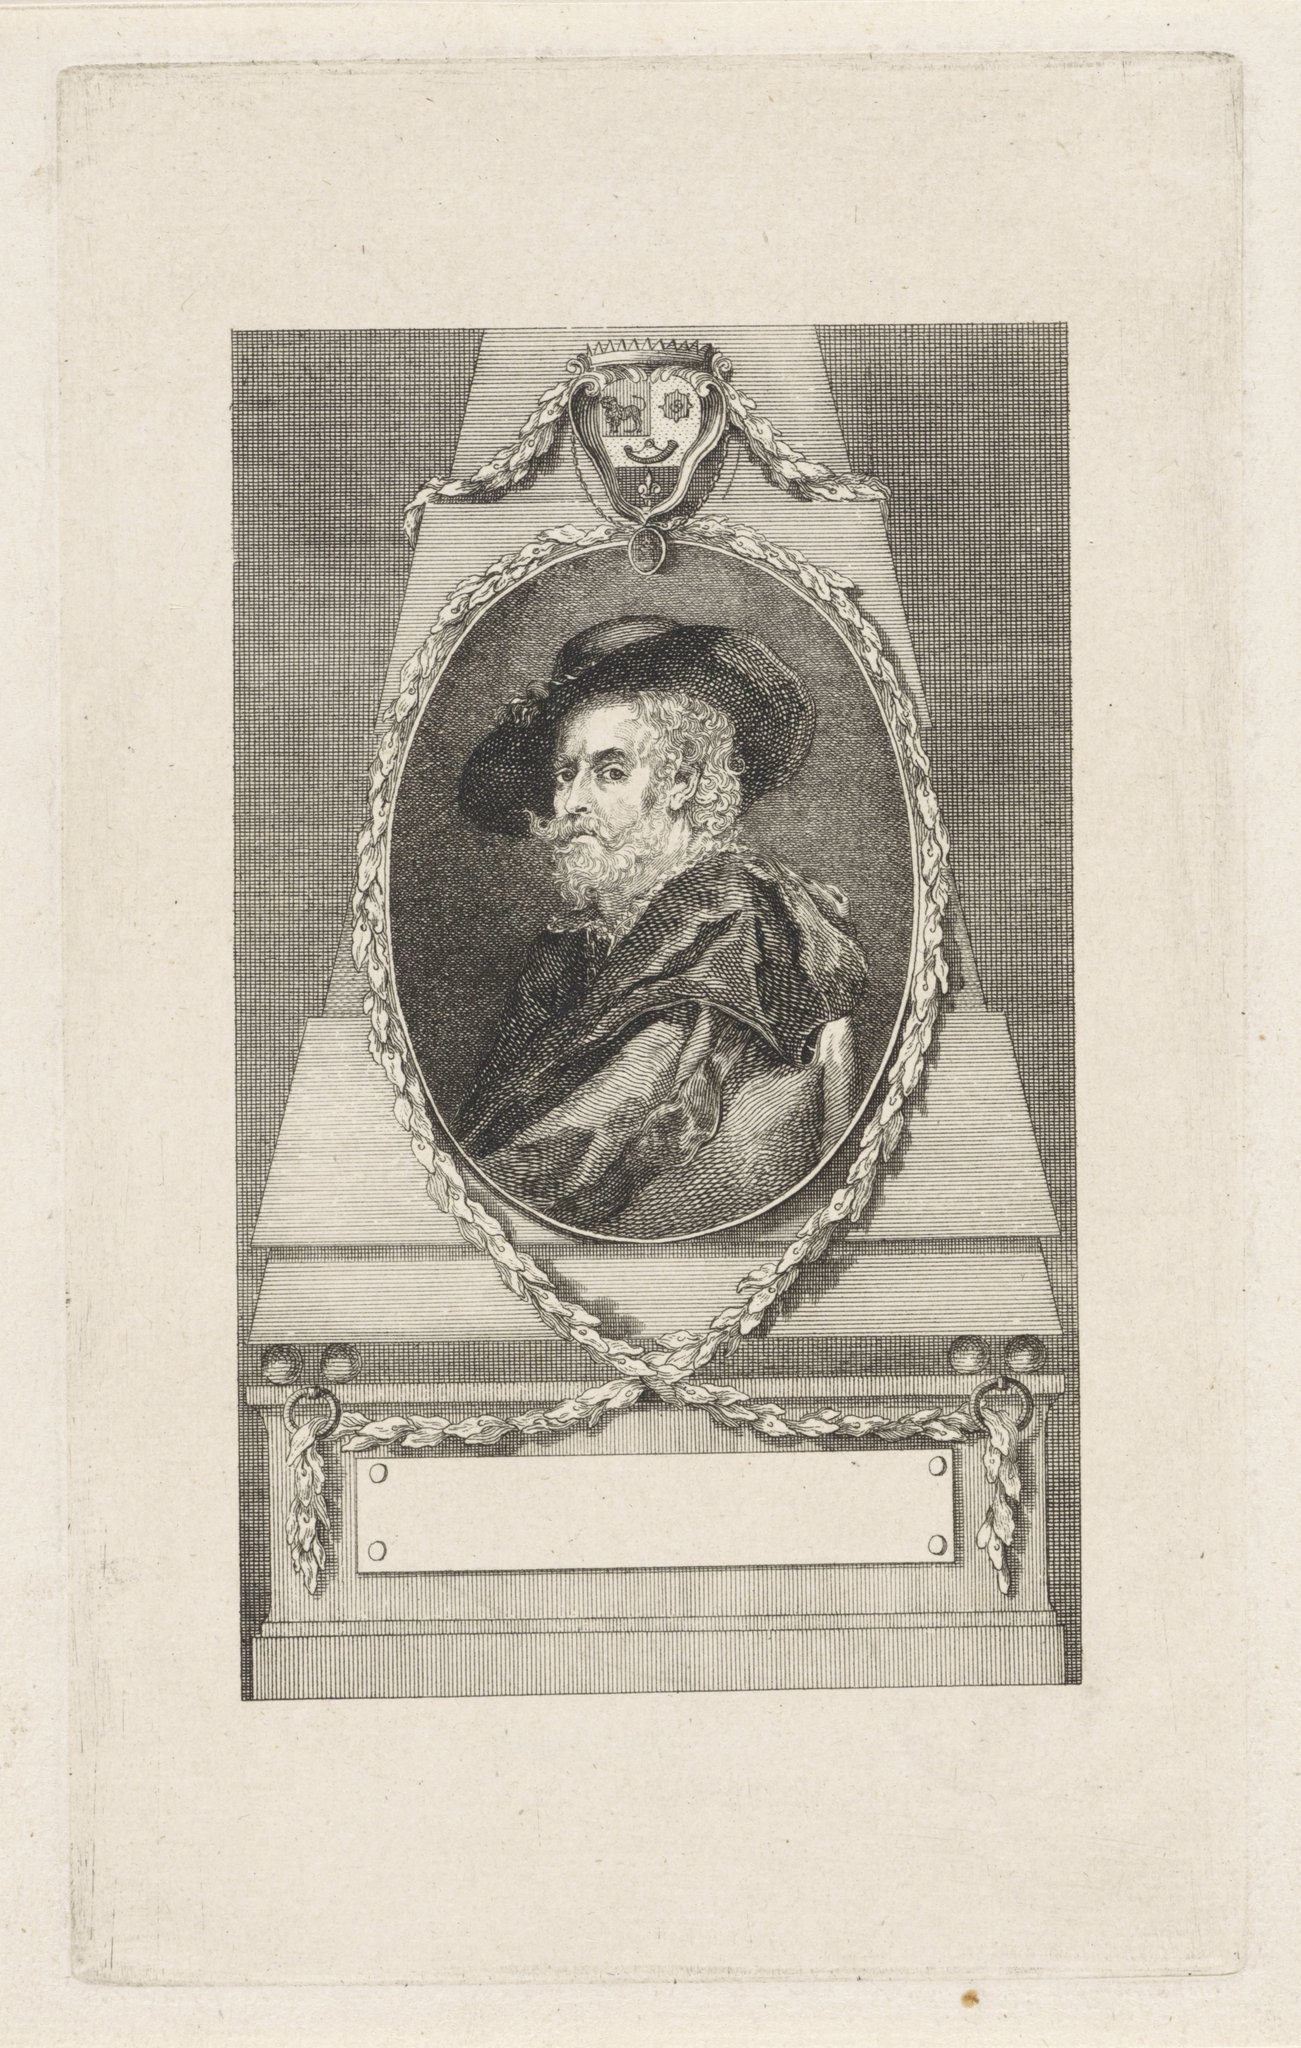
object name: print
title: Portret van Rubens op een zuil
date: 1754-1809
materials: paper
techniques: etching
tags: antwerp, painter, print maker, draughtsman, peter paul rubens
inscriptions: collector's mark: Lugt 240